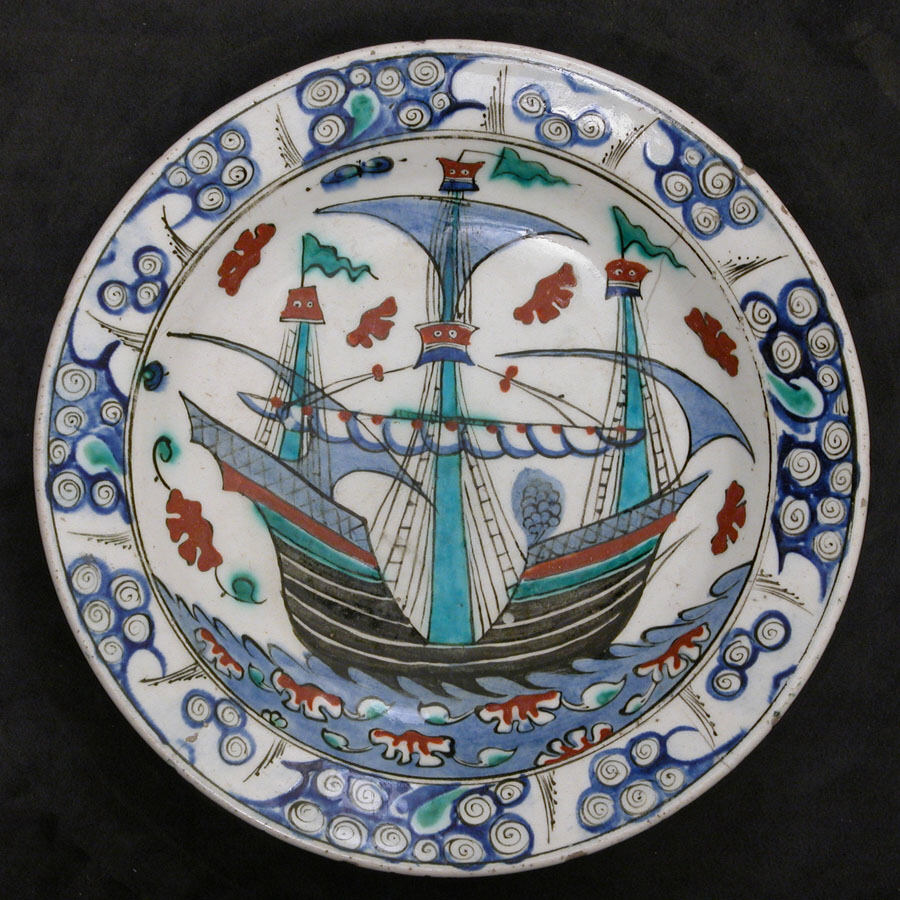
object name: dish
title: Dish with Sailing-ship Design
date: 1600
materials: glaze, stonepaste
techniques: painting, polychrome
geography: turkey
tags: ships